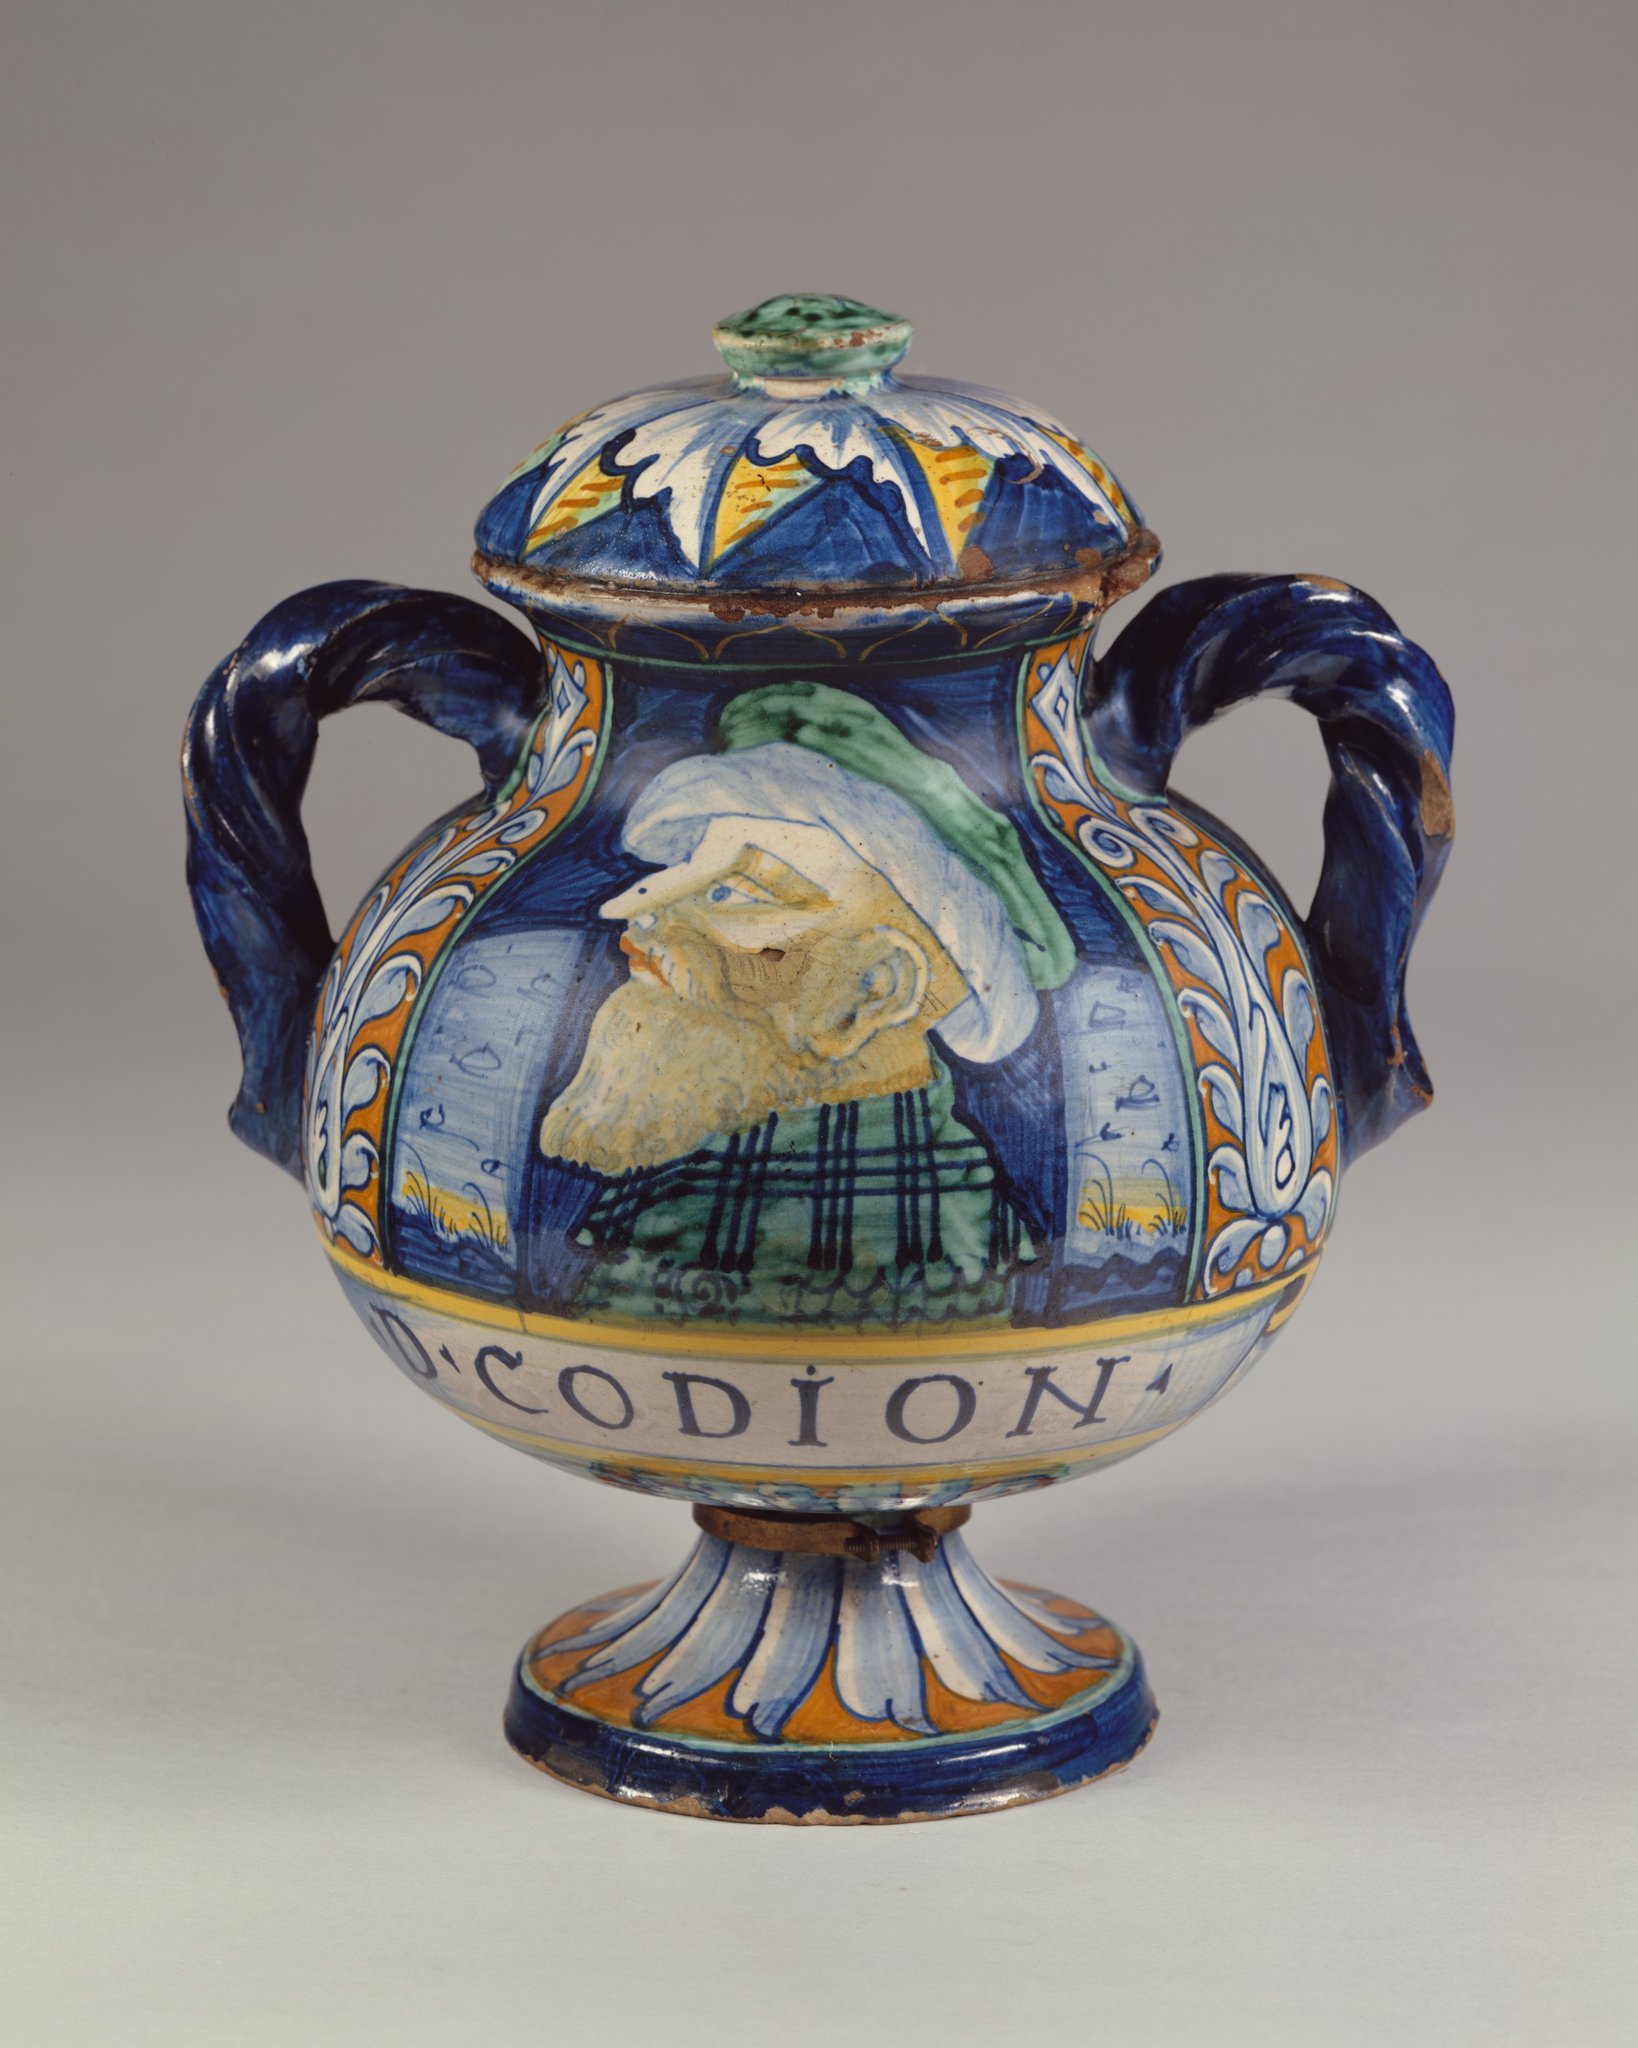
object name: apothecary vase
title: Apothecary vase (vaso da farmacia)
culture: italian, castelli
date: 1530-1540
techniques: maiolica, glazing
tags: men,profiles